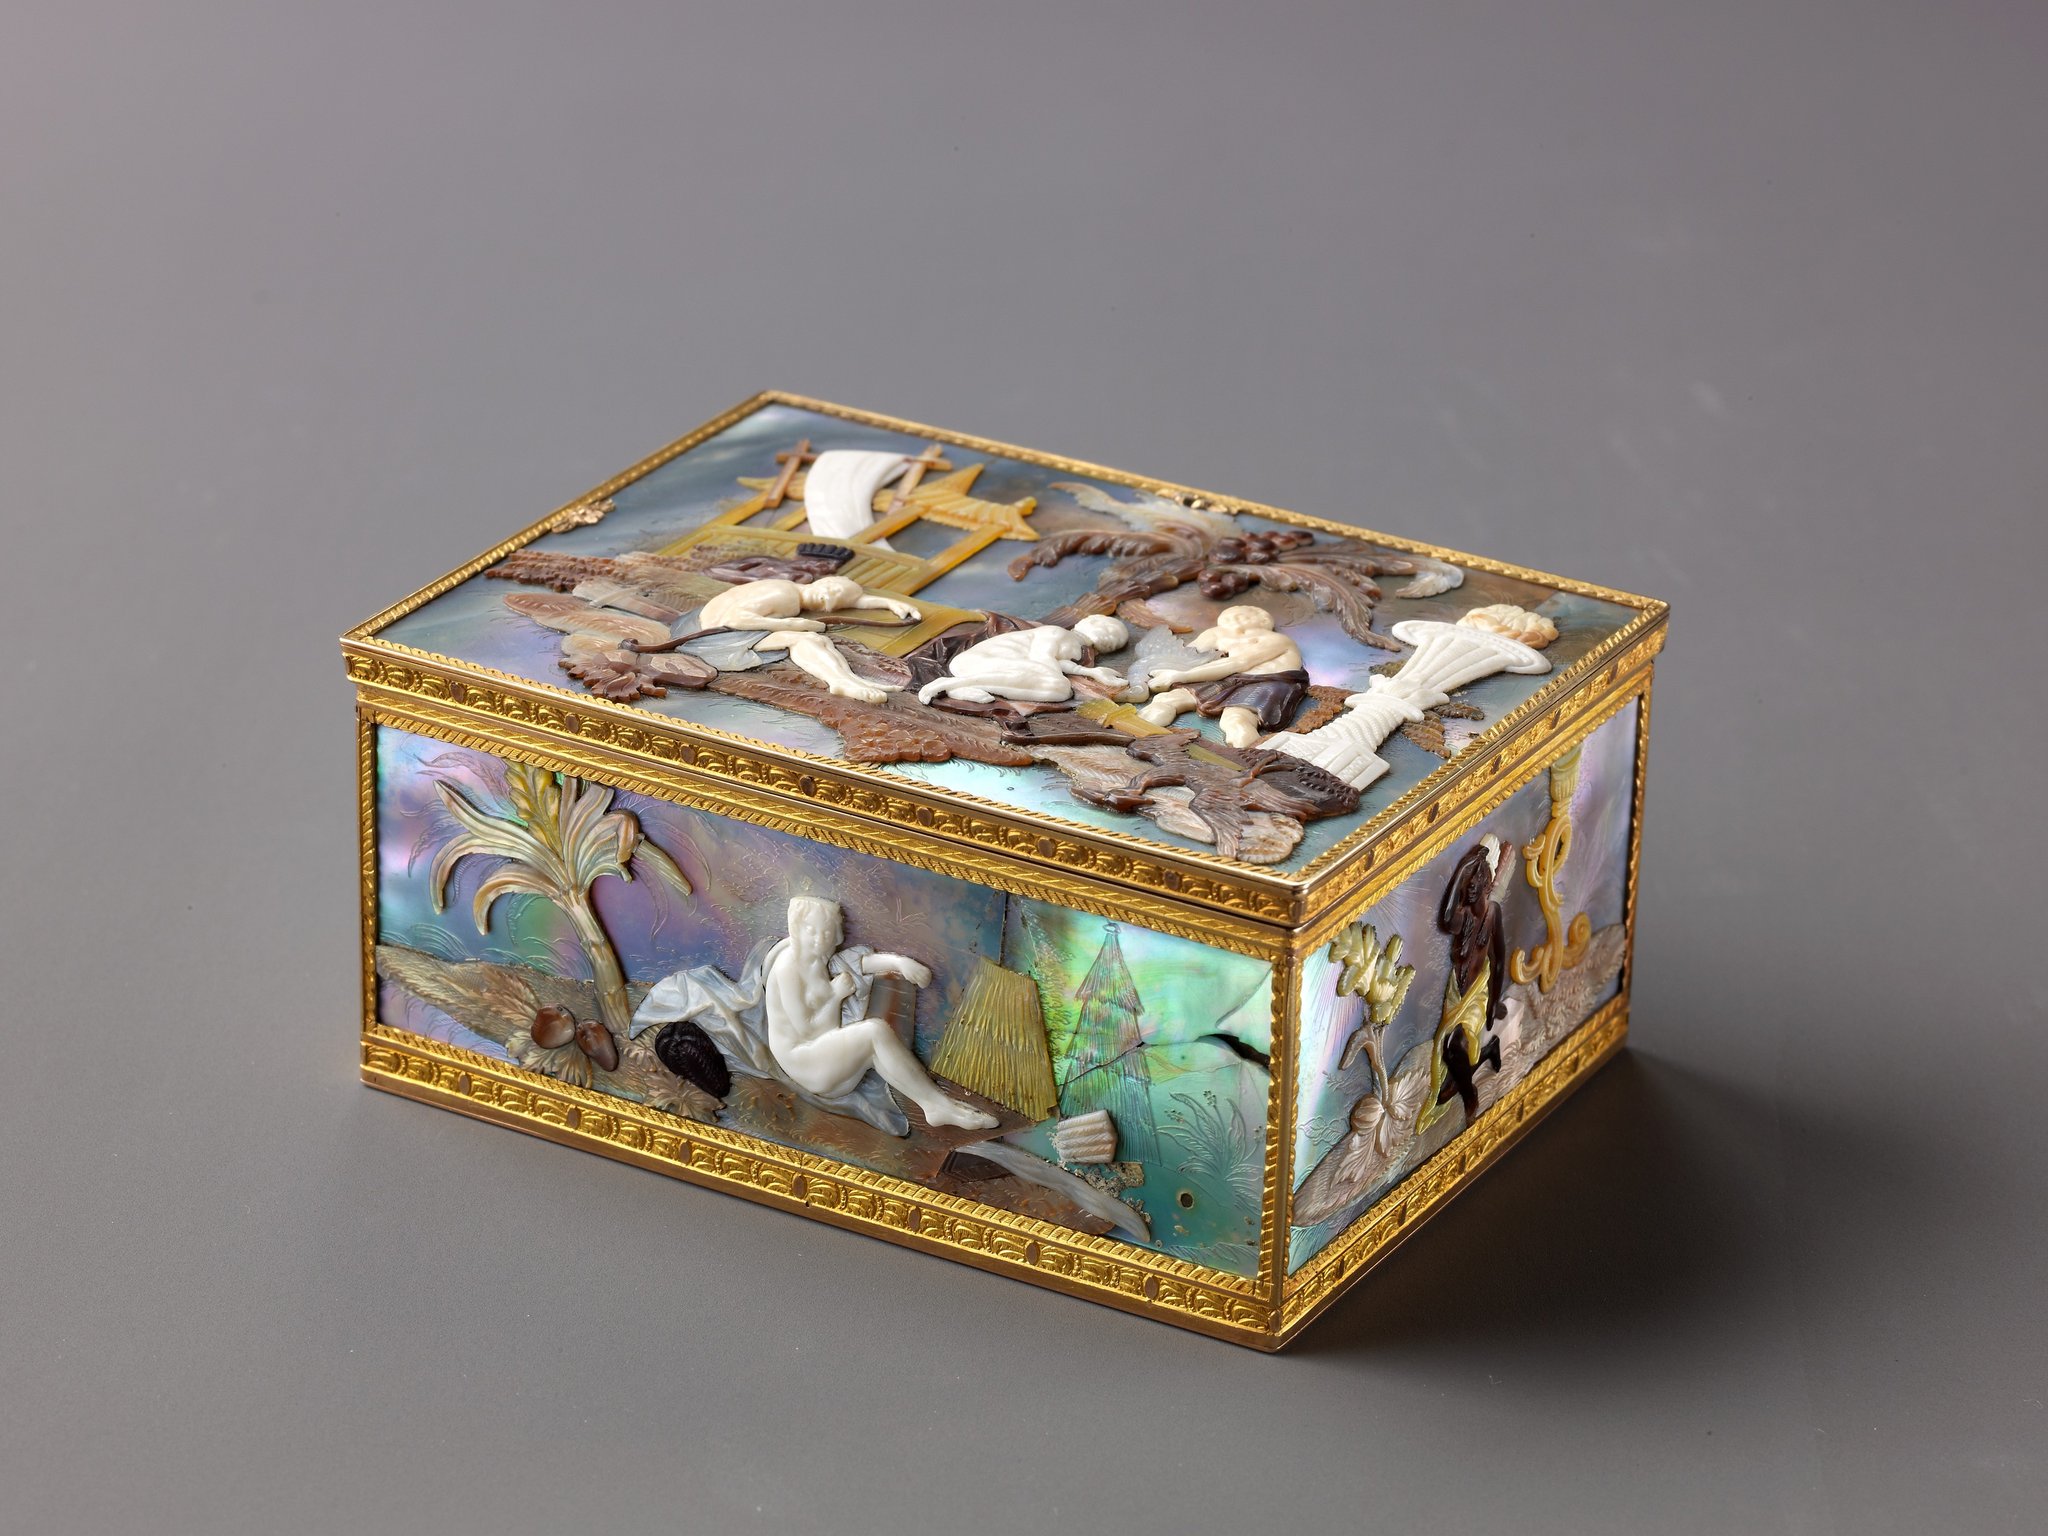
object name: snuffbox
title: Snuffbox with Mother-of-Pearl Decoration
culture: german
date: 1801-1900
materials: gold, ivory, mother of pearl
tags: men,female nudes